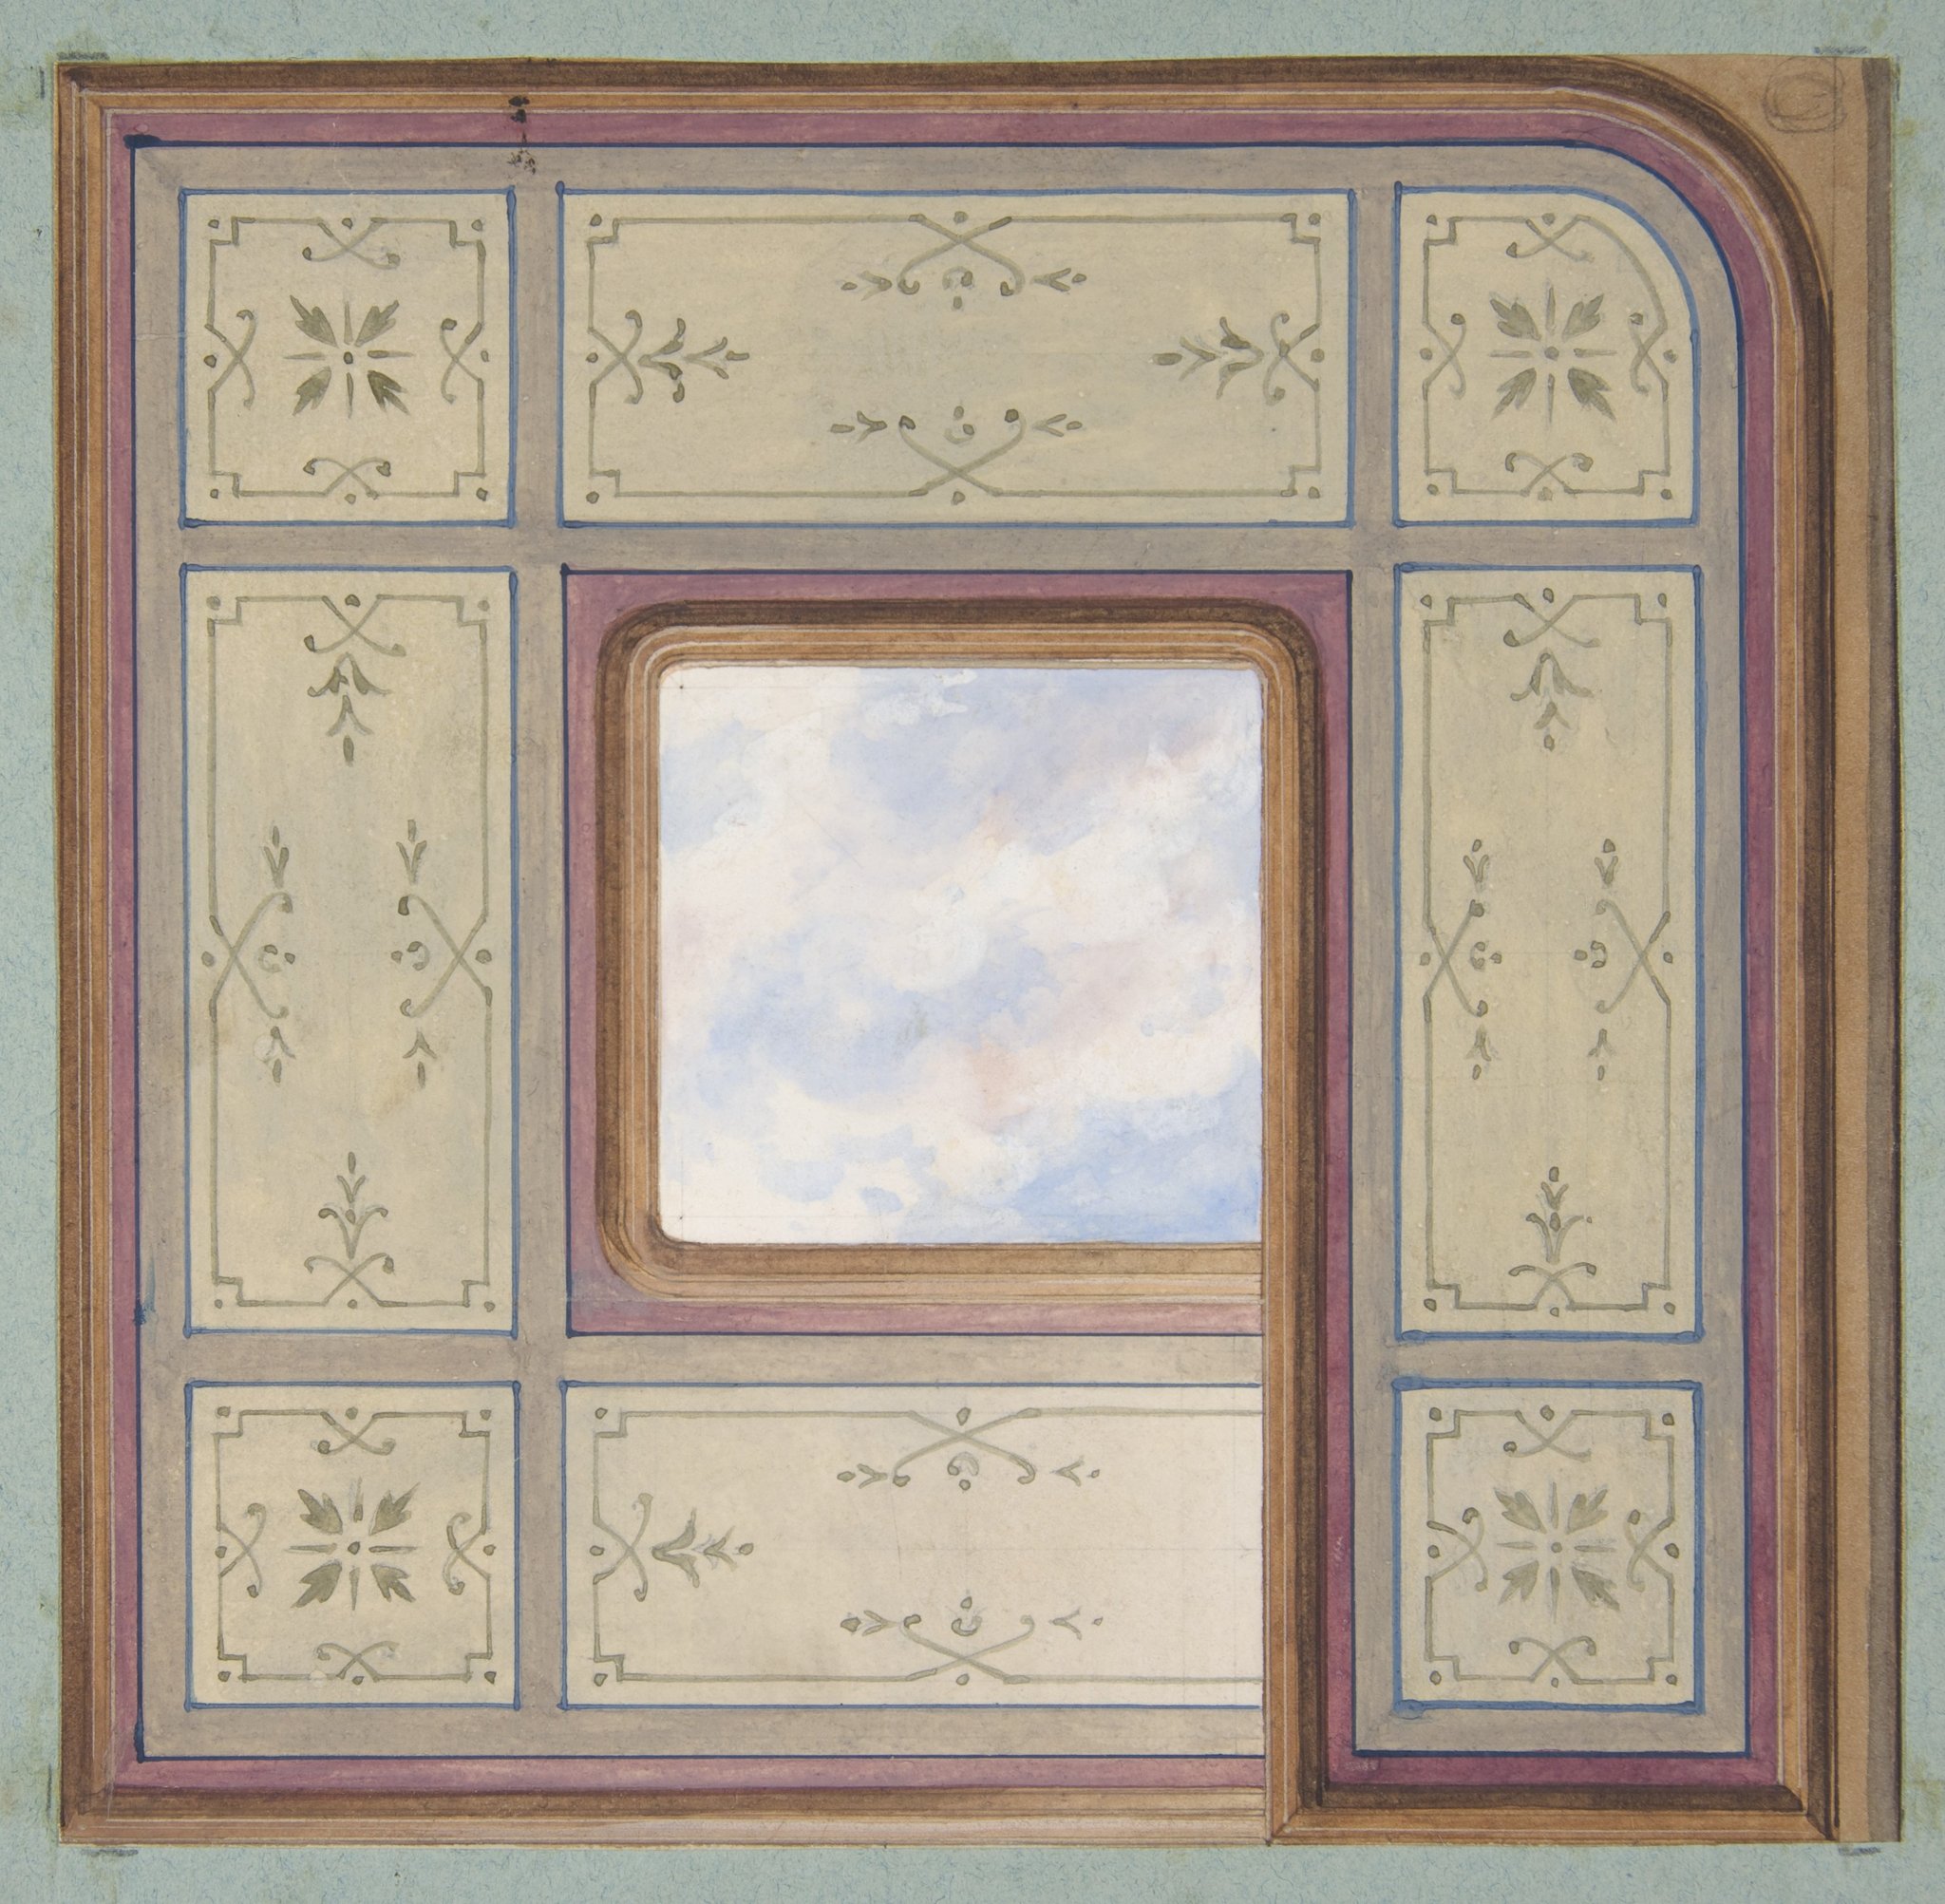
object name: drawing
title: Design for the decoration of a ceiling with a central panel of painted clouds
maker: jules-edmond-charles lachaise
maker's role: artist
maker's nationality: french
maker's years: 1897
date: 1830-1897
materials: gouache, graphite, ink, paper, watercolor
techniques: pen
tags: ceilings